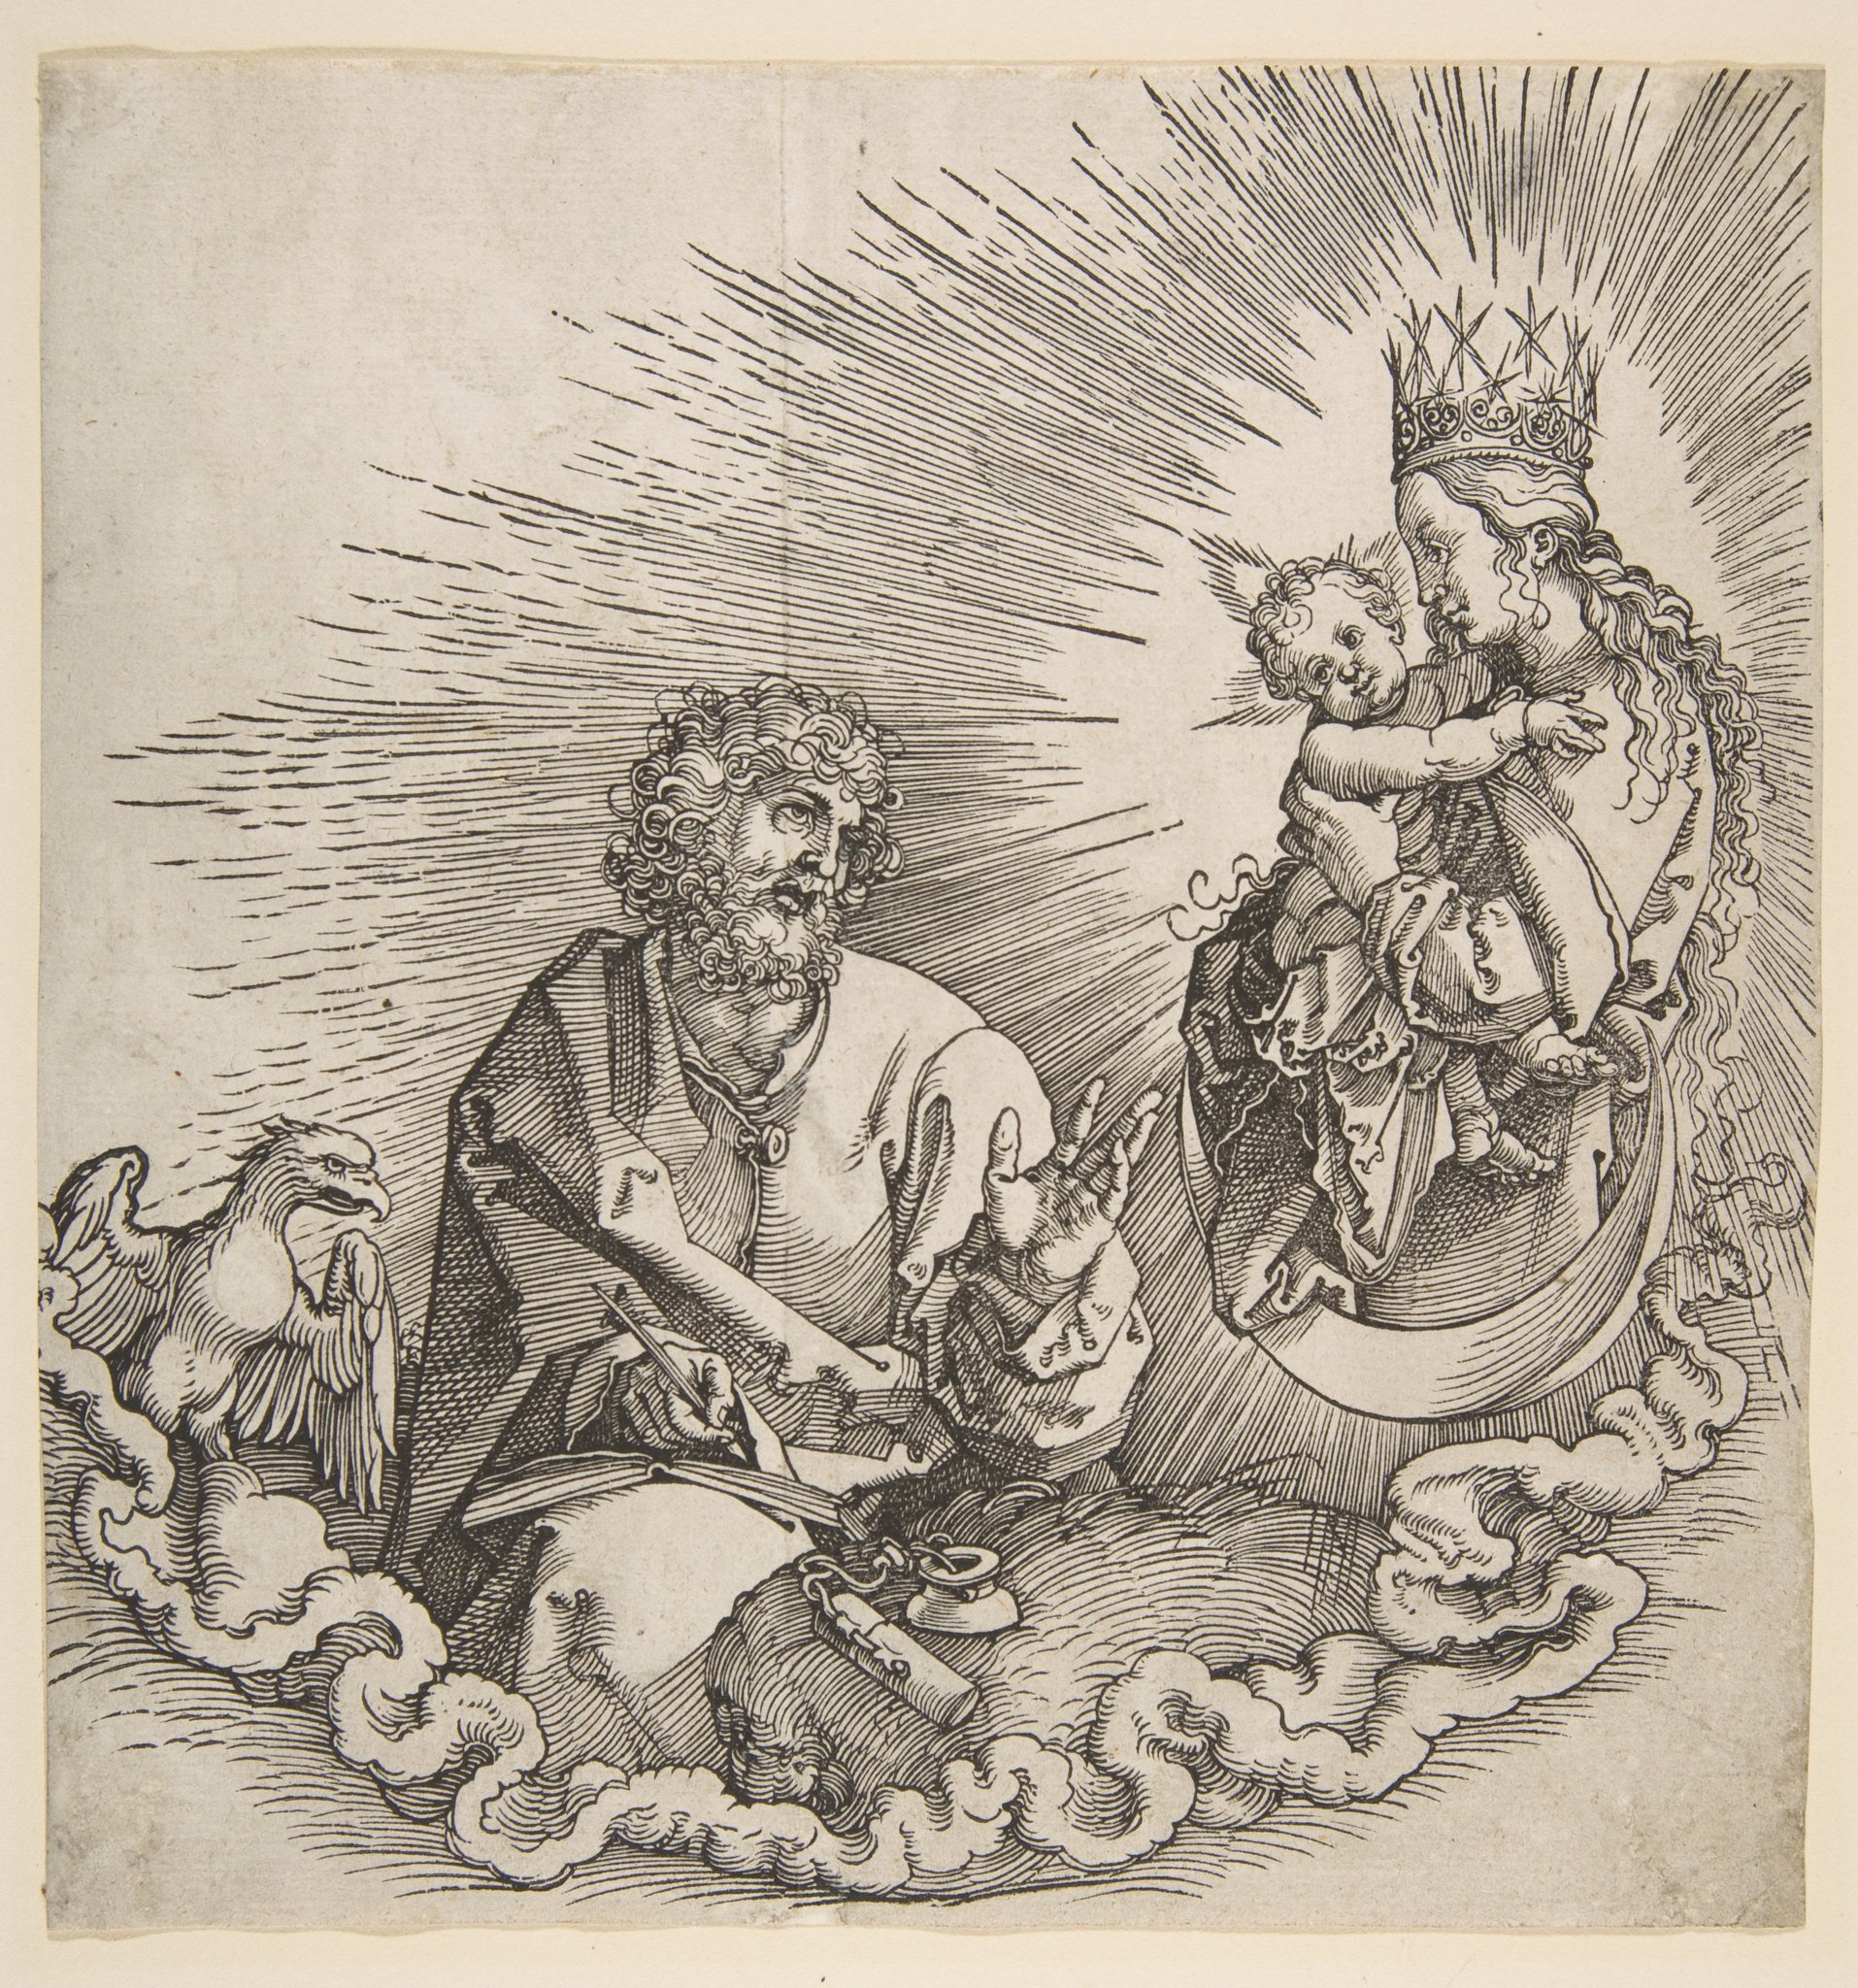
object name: print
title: The Virgin Appearing to Saint John, Frontispiece to the Apocalypse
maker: albrecht dürer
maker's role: artist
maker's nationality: german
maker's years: 1471-1528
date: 1511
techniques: woodcut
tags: eagles,saint john the baptist,virgin mary